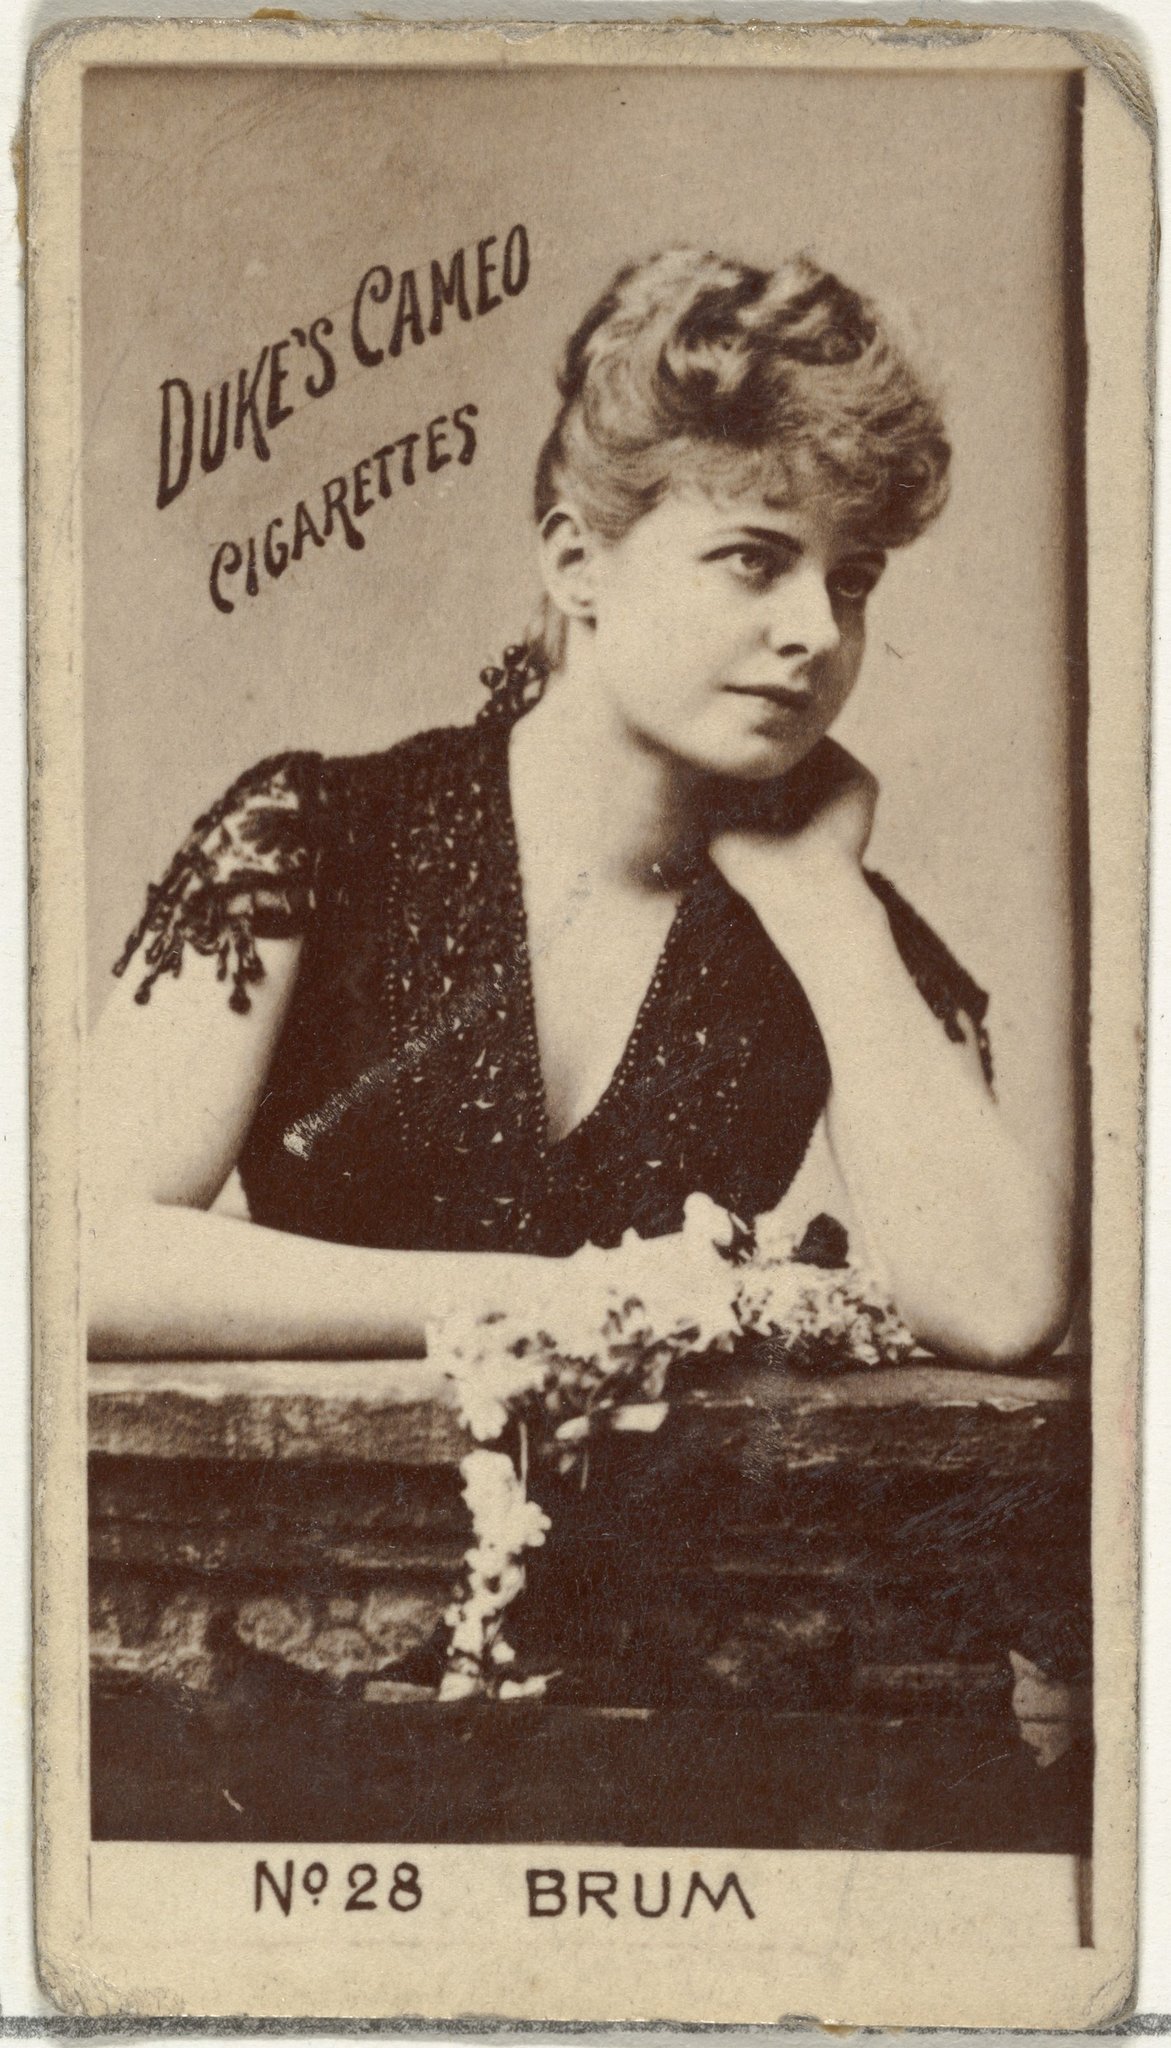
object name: photograph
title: Card Number 28, Miss Brum, from the Actors and Actresses series (N145-4) issued by Duke Sons & Co. to promote Cameo Cigarettes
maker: w. duke, sons & co.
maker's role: publisher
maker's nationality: american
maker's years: 1870-1920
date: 1880-1889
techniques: albumen silver print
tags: portraits,women,actresses